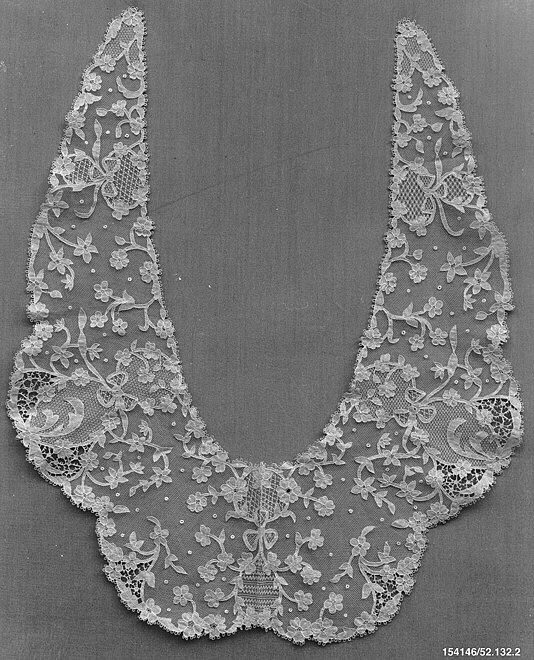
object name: collar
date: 1867-1900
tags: flowers